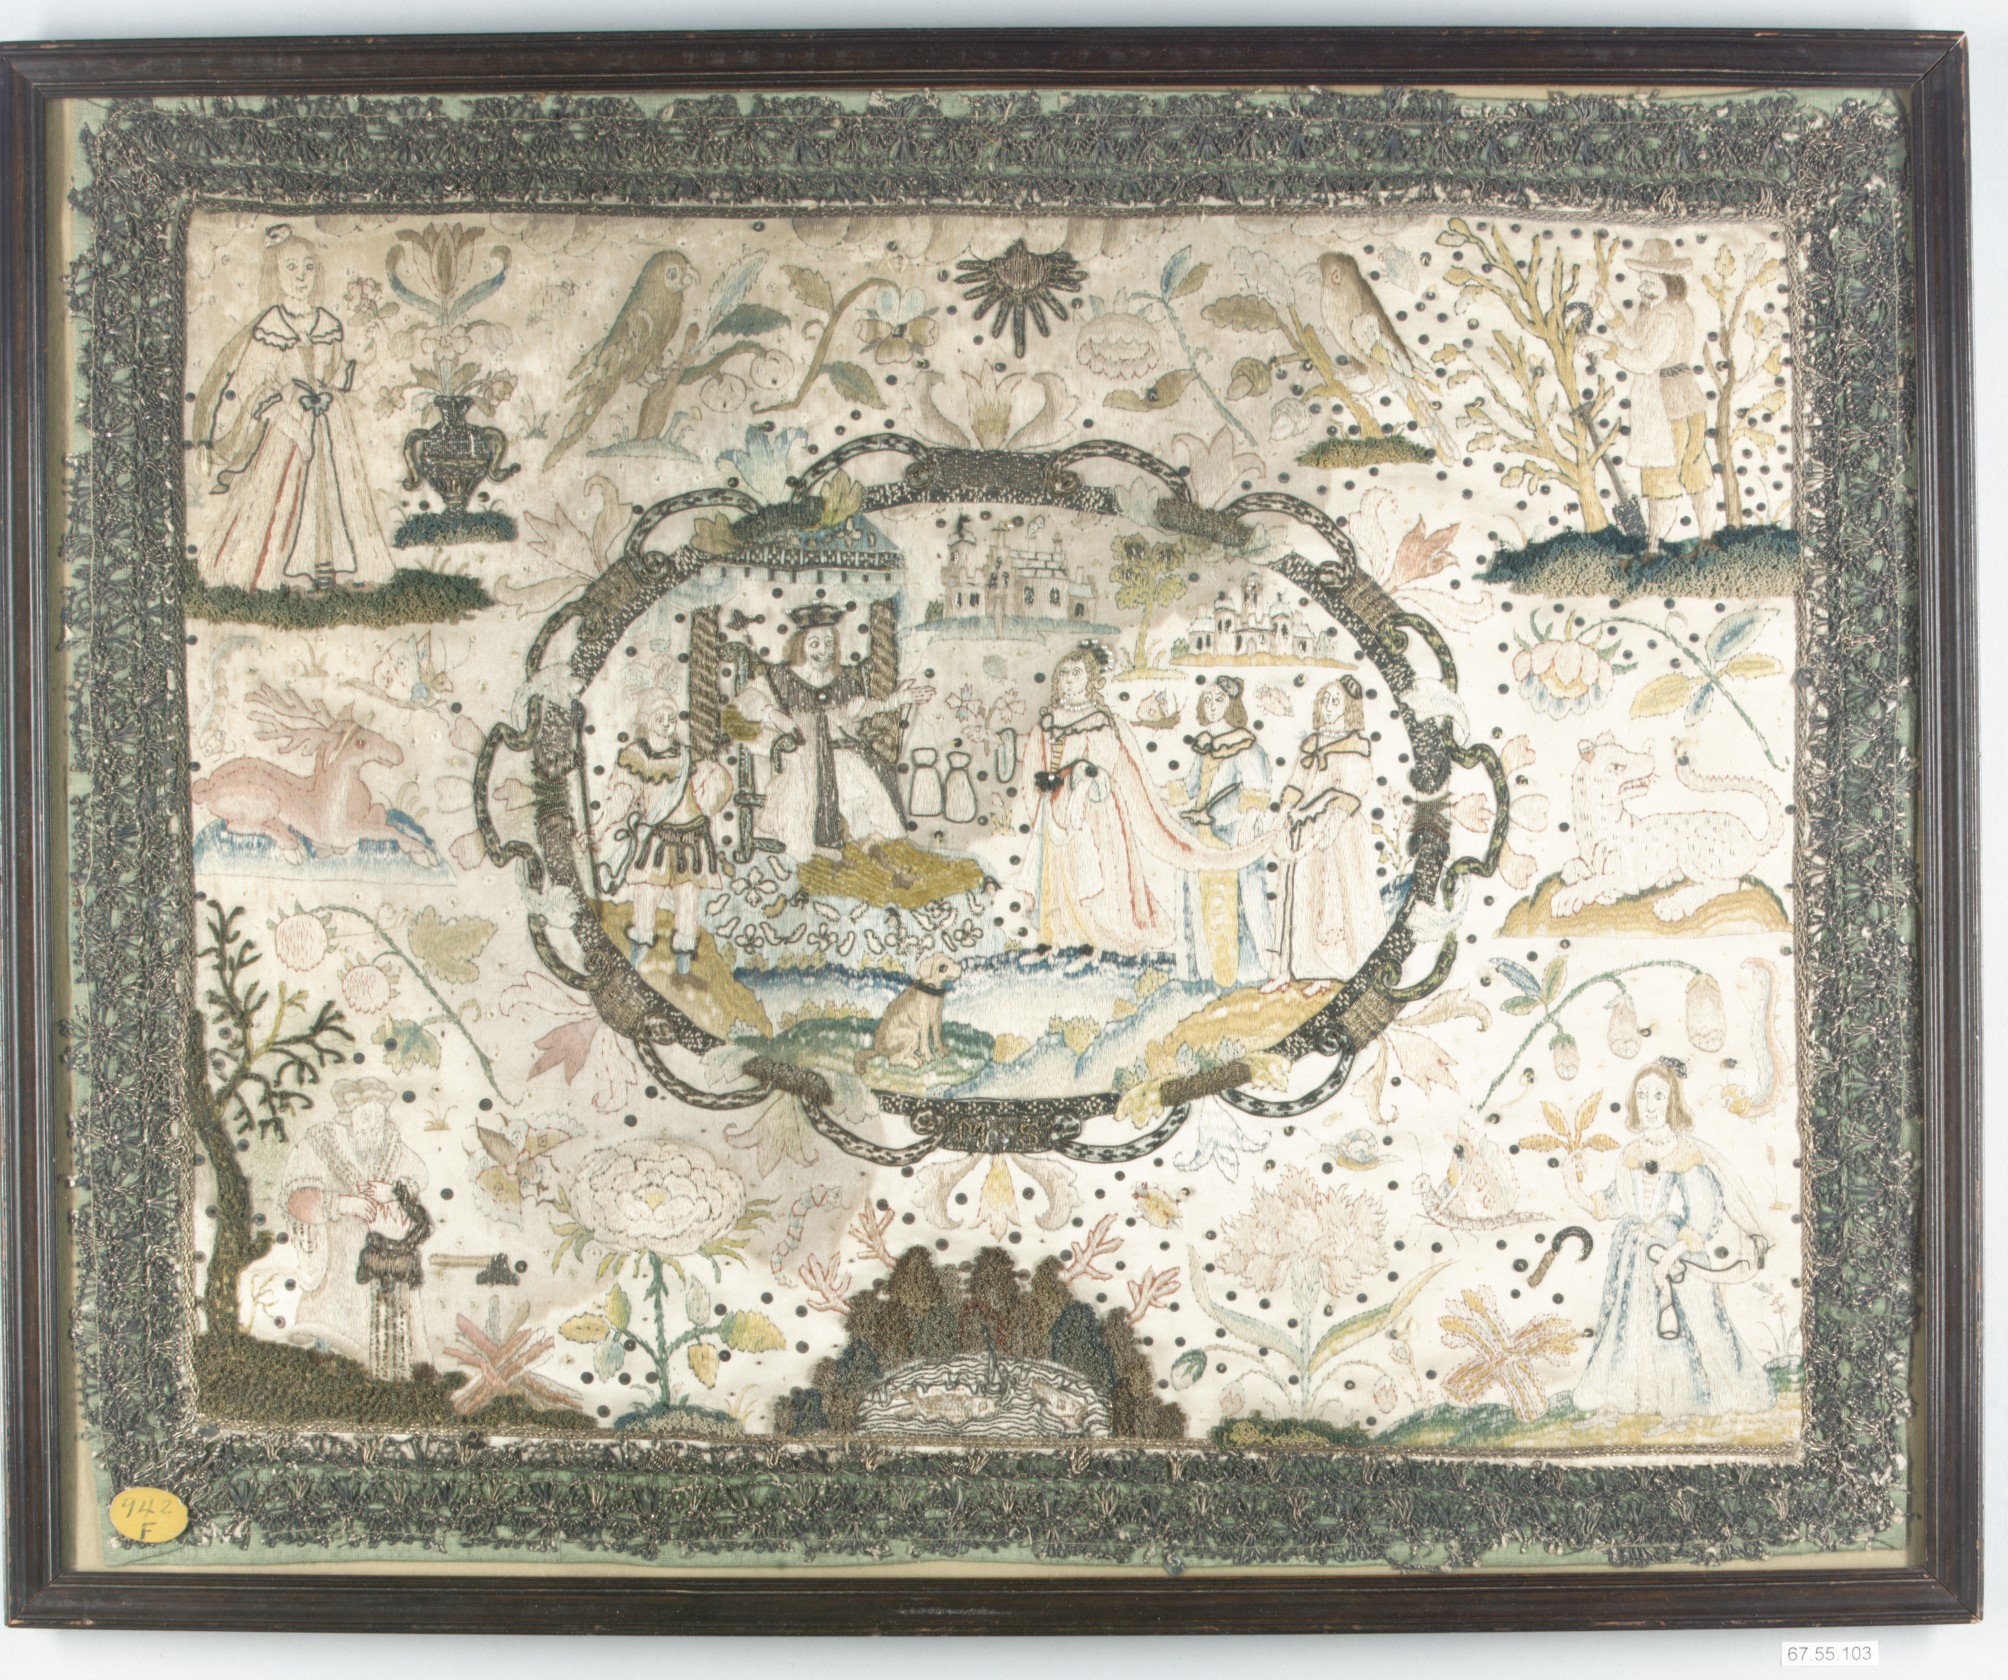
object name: casket top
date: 1601-1700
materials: metal thread, silk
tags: birds,men,women,cheetahs,deer,flowers